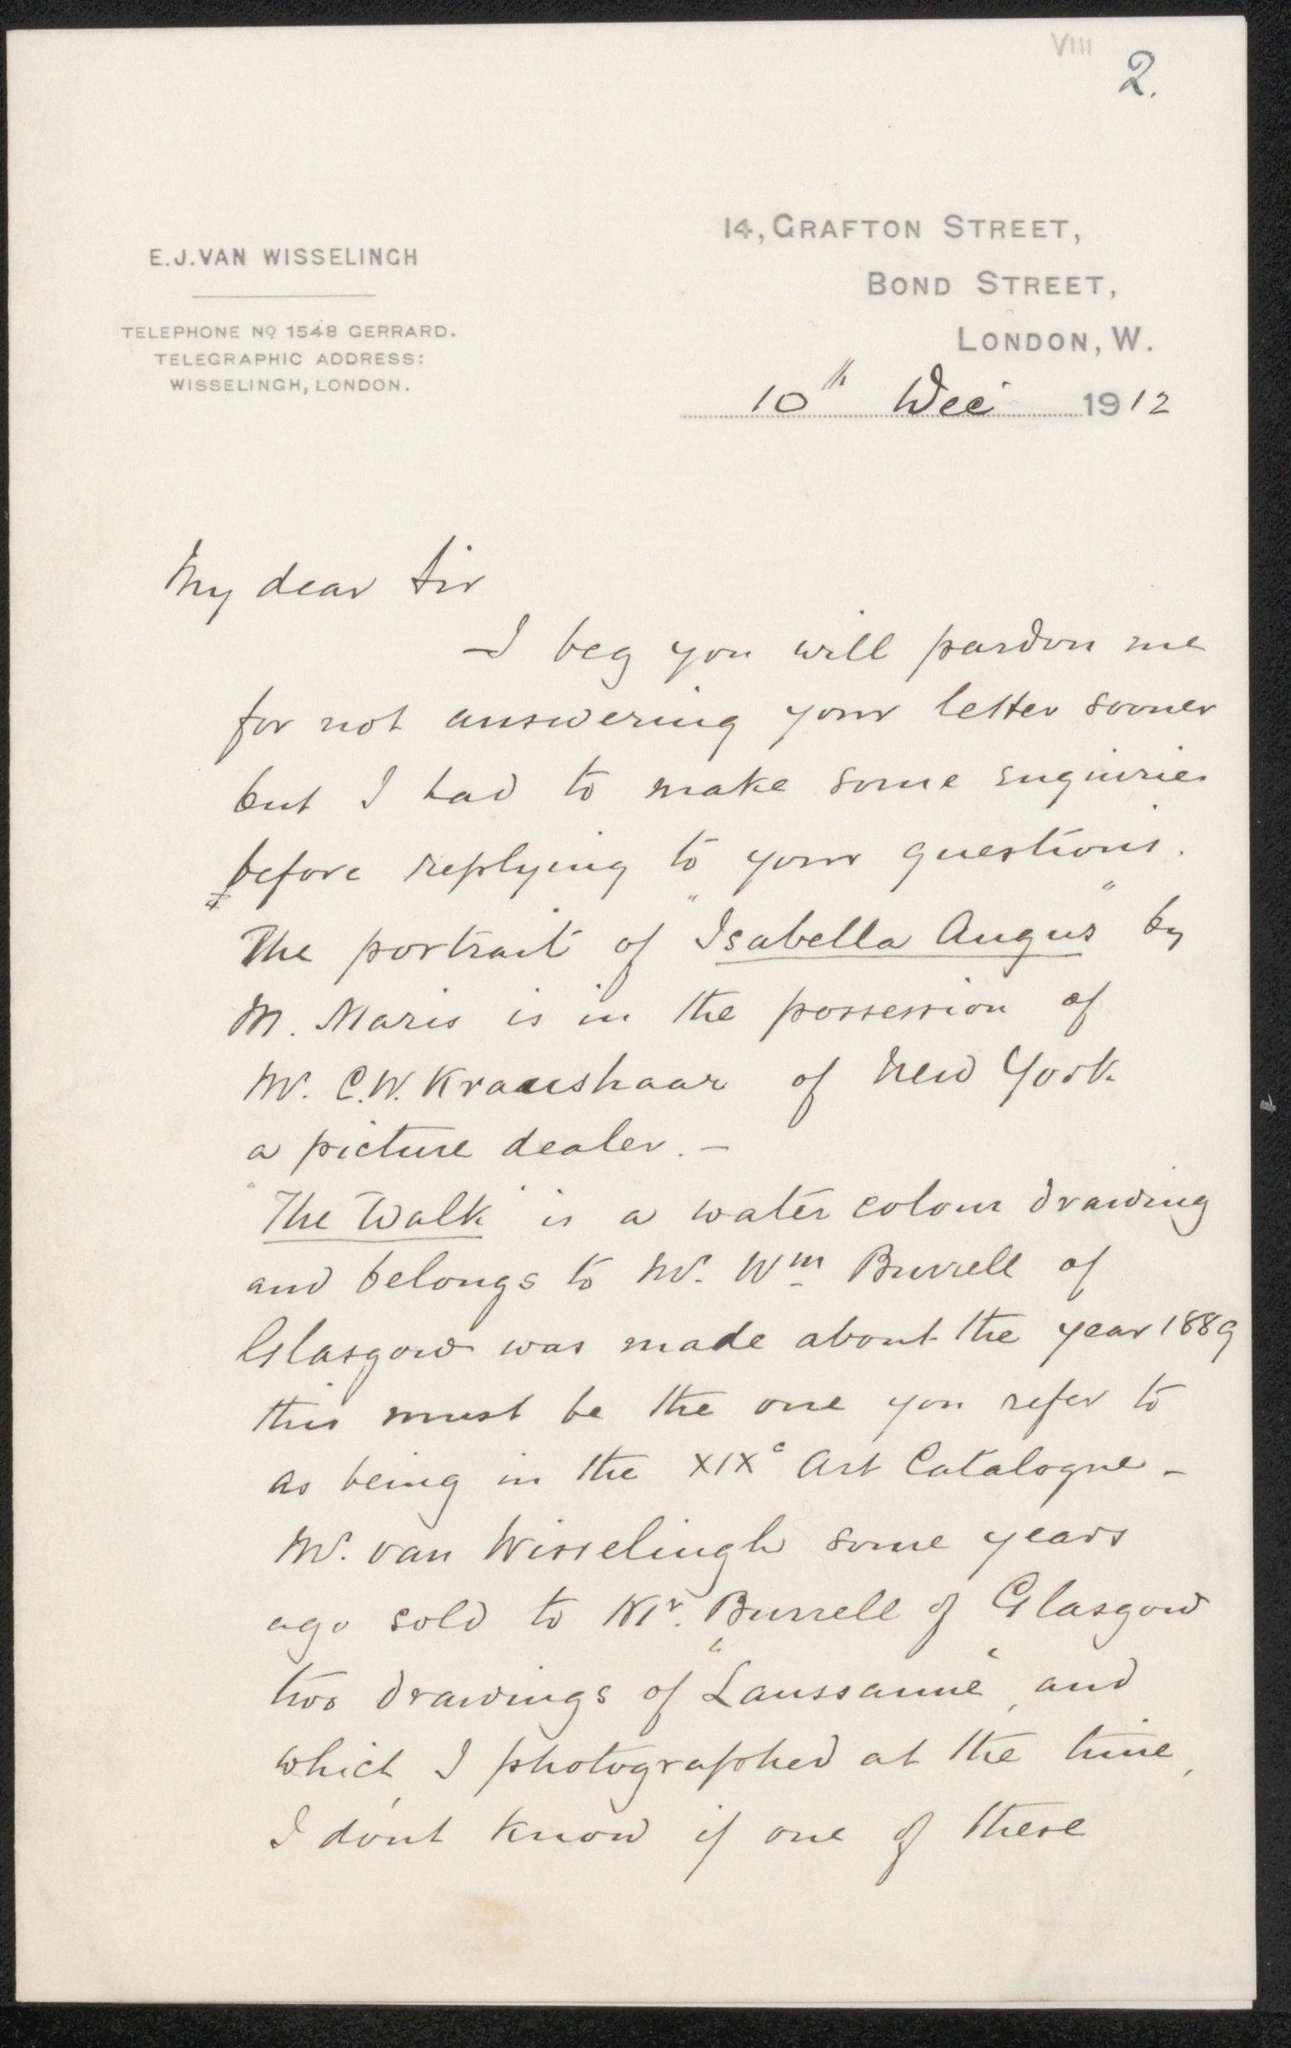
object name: letter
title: Brief aan Pieter Haverkorn van Rijsewijk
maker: george r. reid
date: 1912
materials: ink, paper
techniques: pen, printing, writing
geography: london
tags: glasgow, william burrell, the hague, london, painter, print maker, draughtsman, matthijs maris, pieter haverkorn van rijsewijk, elbert jan van wisselingh, isabella murray mowat angus, art trade, art shop, drawing, photography, cinematography, painting (including book-illumination, miniature-painting), historical persons (portraits and scenes from the life)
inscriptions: watermark